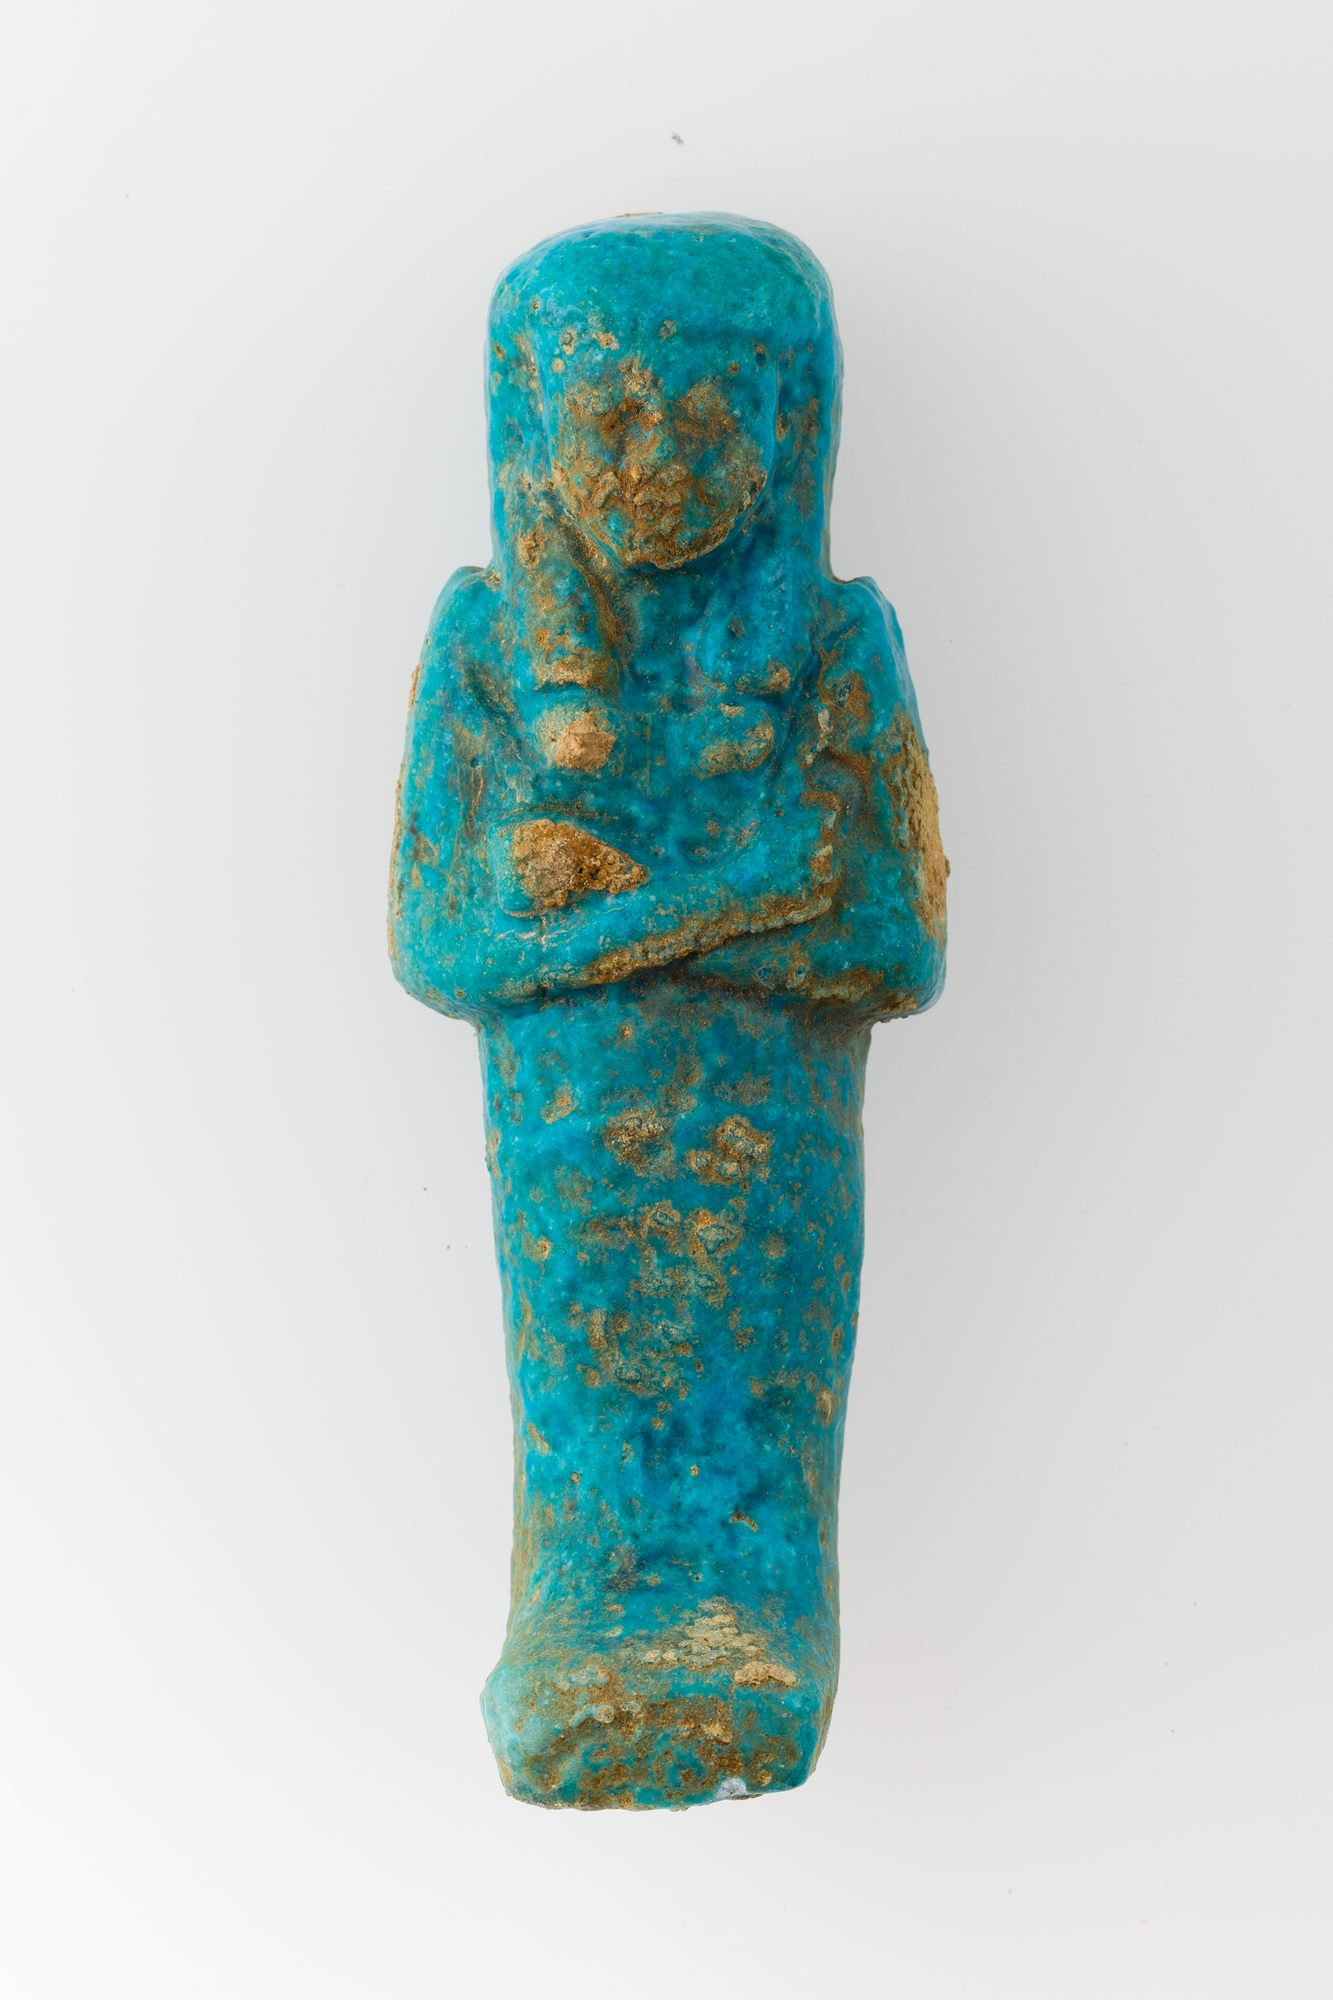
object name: shabti, henettawy c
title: Worker Shabti of Henettawy (C), Daughter of Isetemkheb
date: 990-970 BCE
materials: faience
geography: egypt